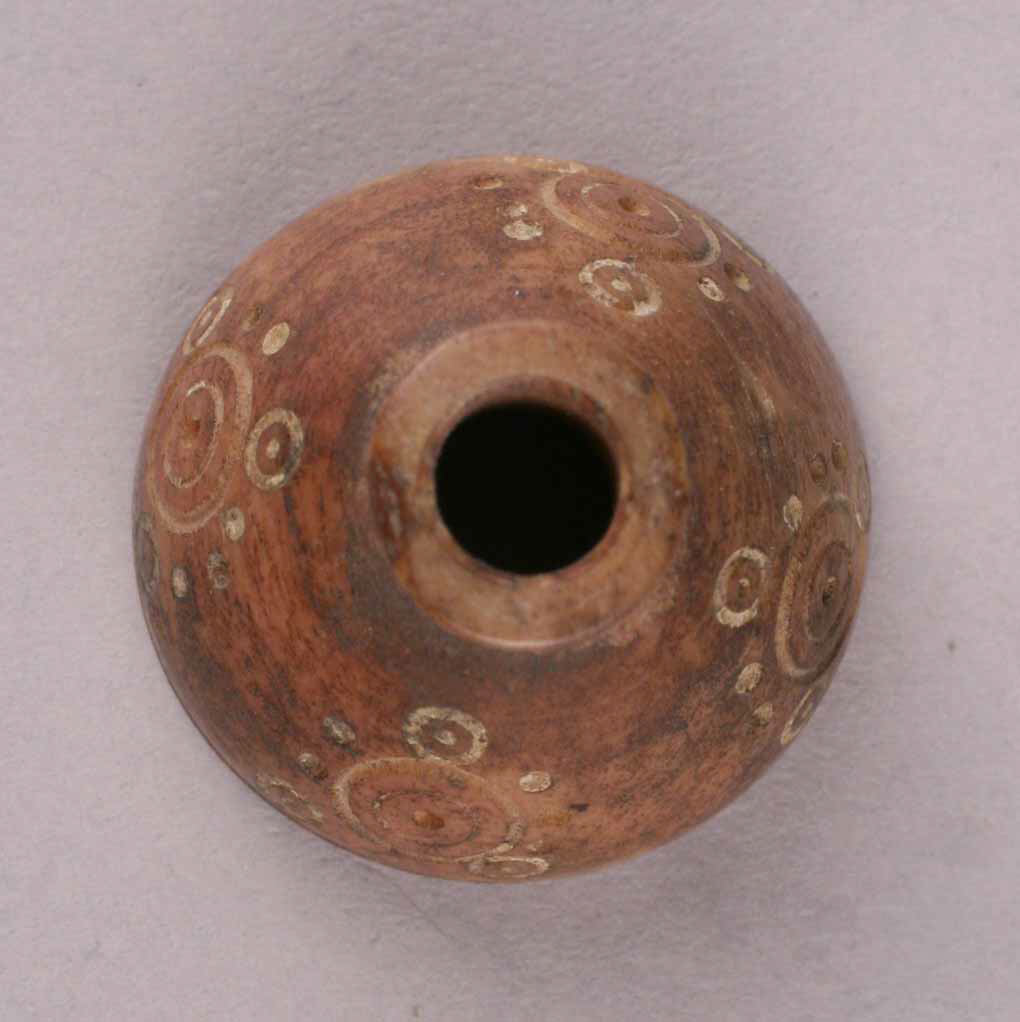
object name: spindle whorl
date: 801-1000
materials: bone, paint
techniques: incising, inlay, tinting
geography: iran